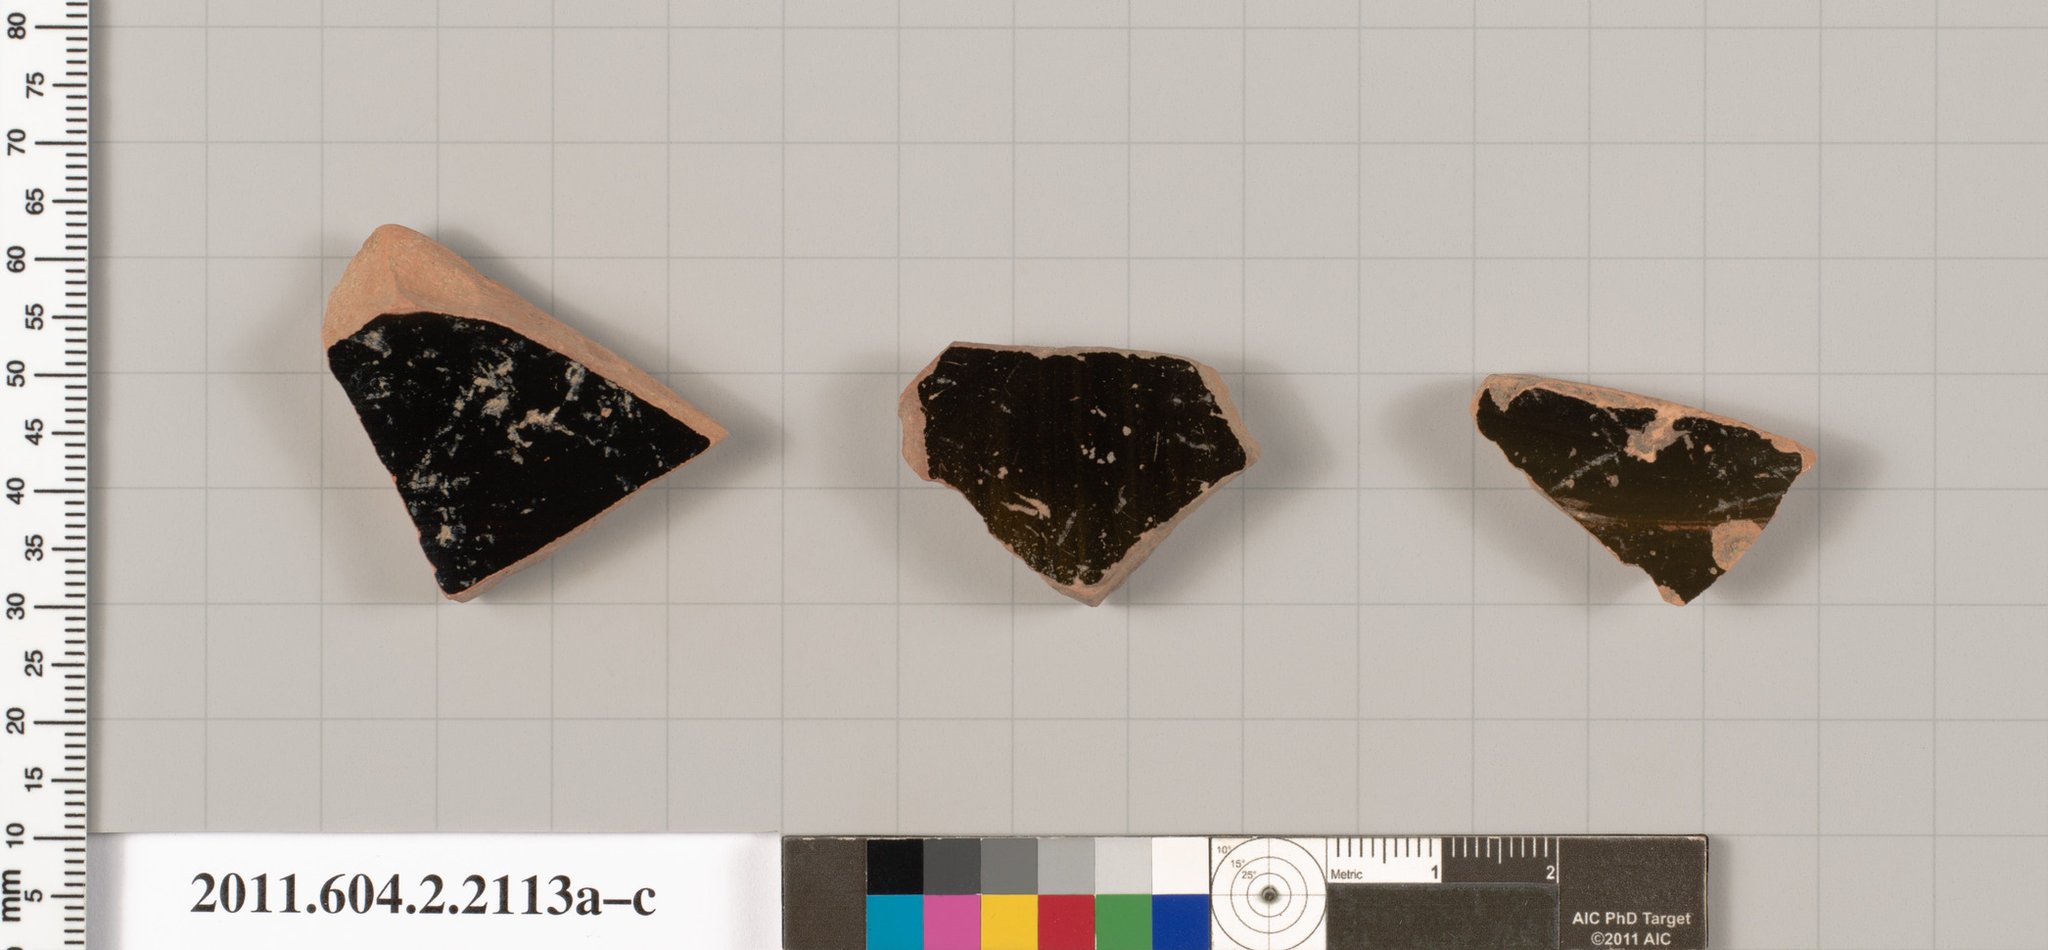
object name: pot fragment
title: Terracotta fragments of pots; glazed on the inside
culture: greek, attic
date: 600-401 BCE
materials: terracotta